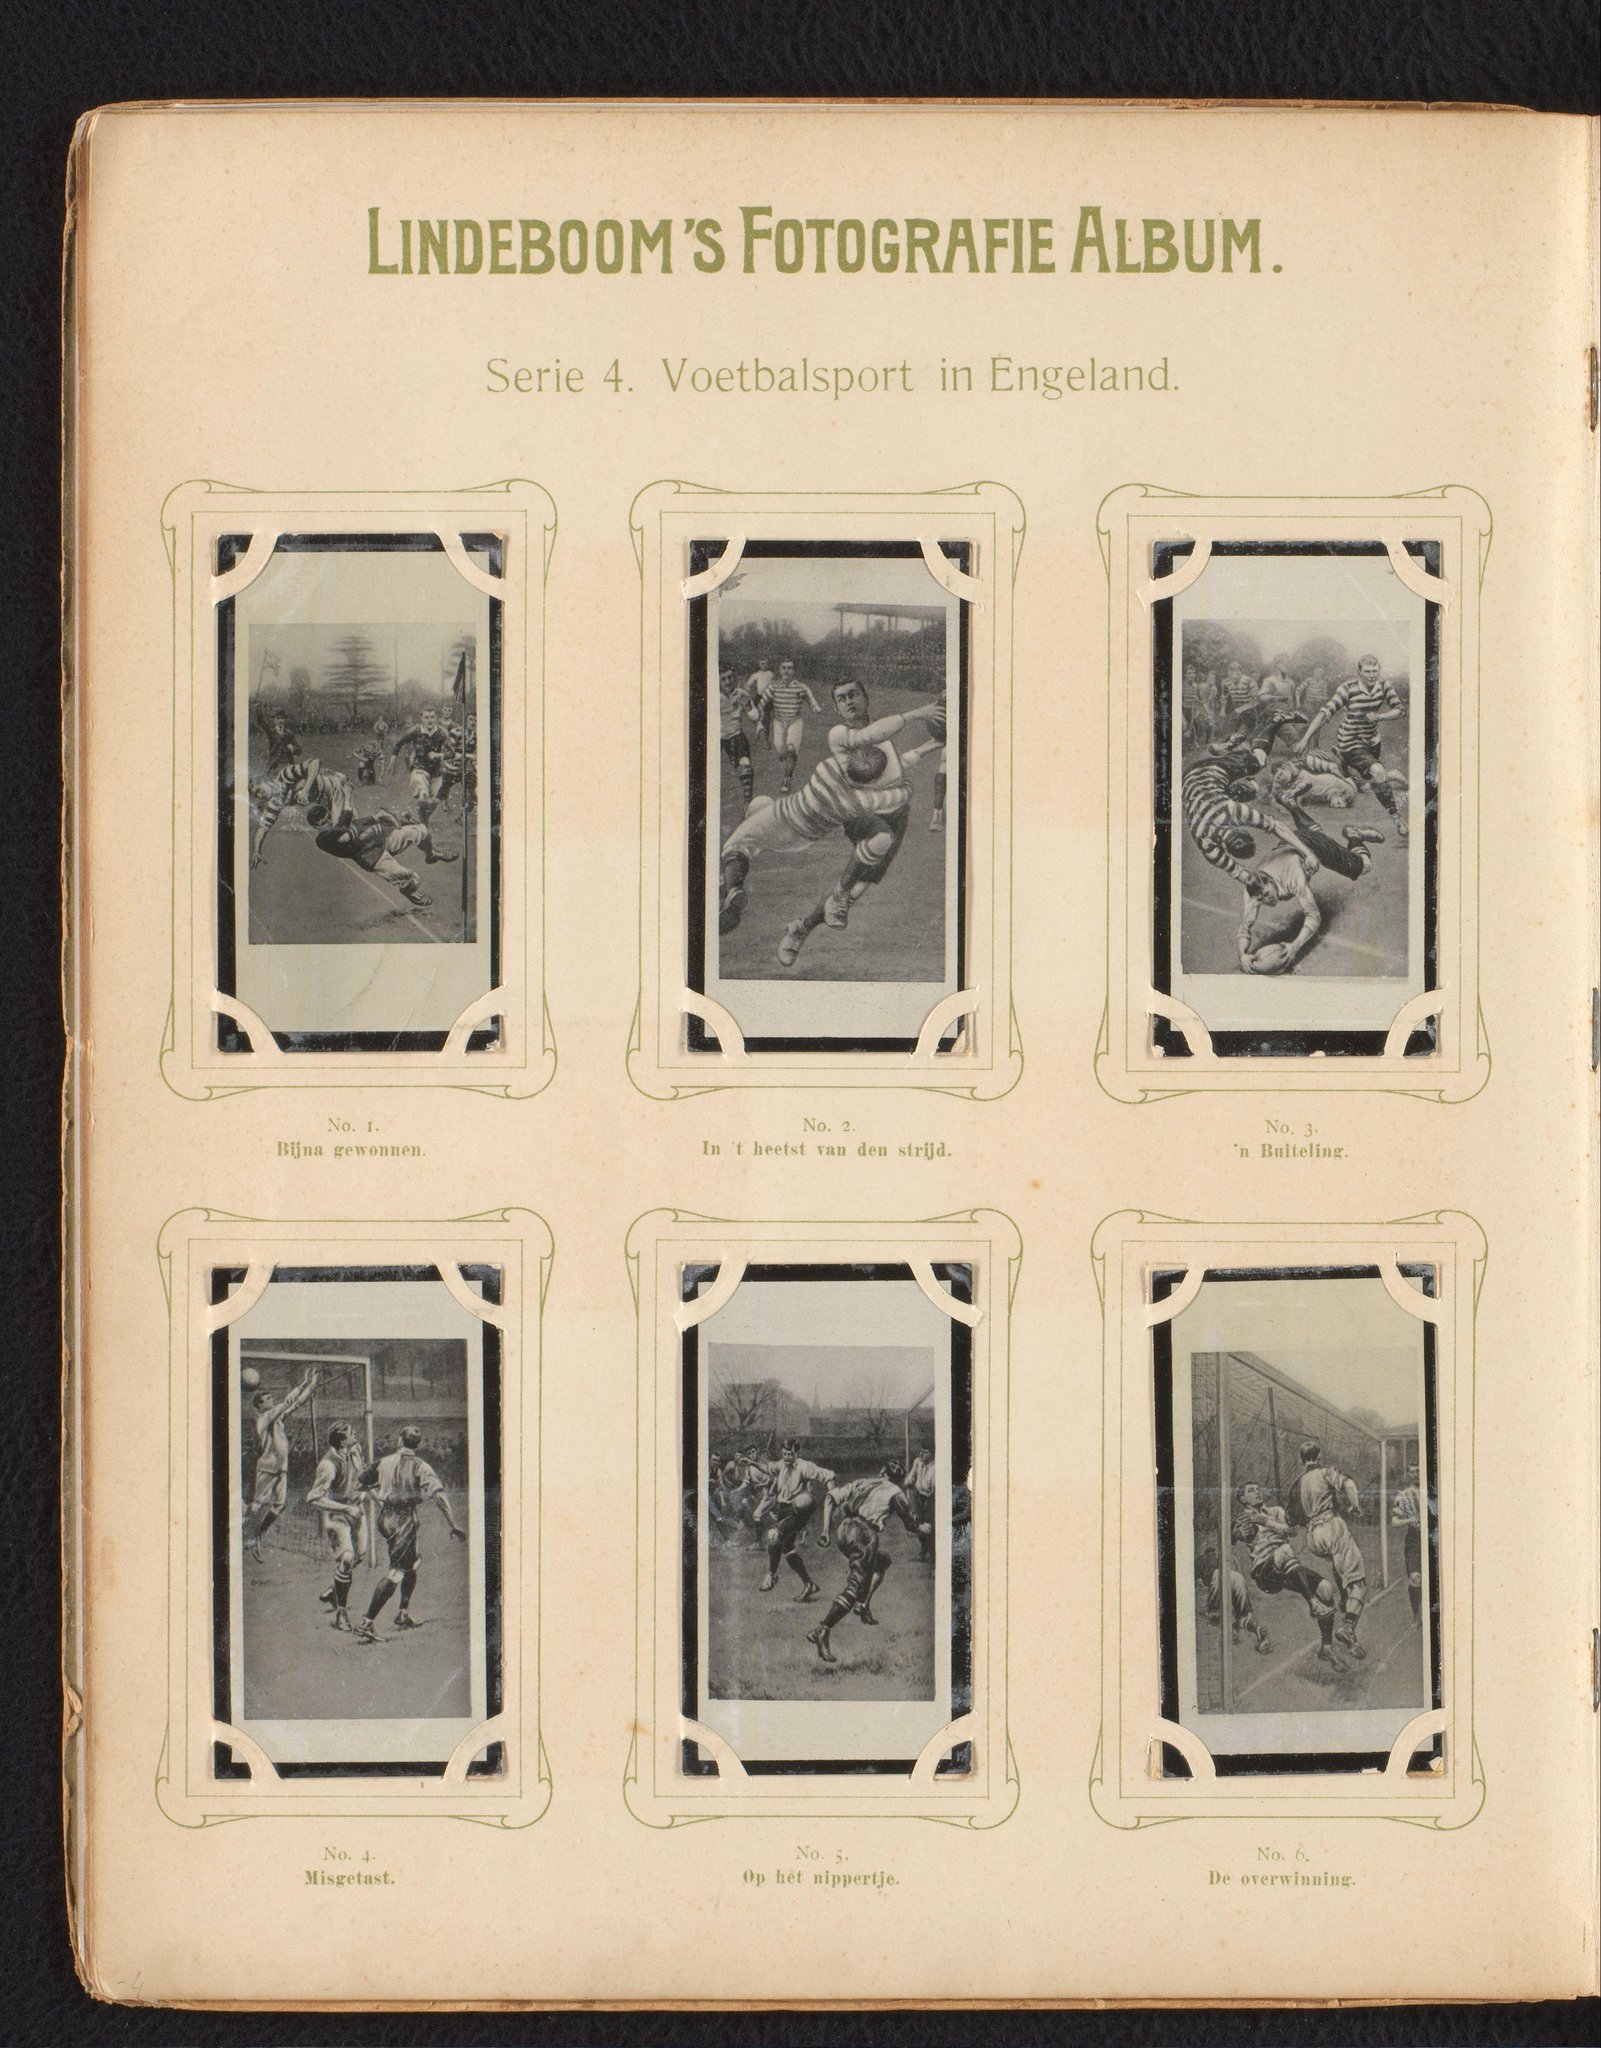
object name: photomechanical print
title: Zes reproducties van tekeningen van een voetbalwedstrijd in Engeland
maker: Anonymous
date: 1905-1906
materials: cardboard, paper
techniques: photograph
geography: amsterdam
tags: soccer, football (early names: soule, choule, cholle)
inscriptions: inscription: ‘Serie 4.’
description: Dergelijke prenten stonden bekend als 'zwartjes'. Men verkreeg ze bij aanschaf van bepaalde merken thee, cacao, sigaretten, beschuit, etc. om te verzamelen. Er waren speciaal voor de 'zwartjes' vervaardigde verzamelalbums in omloop.